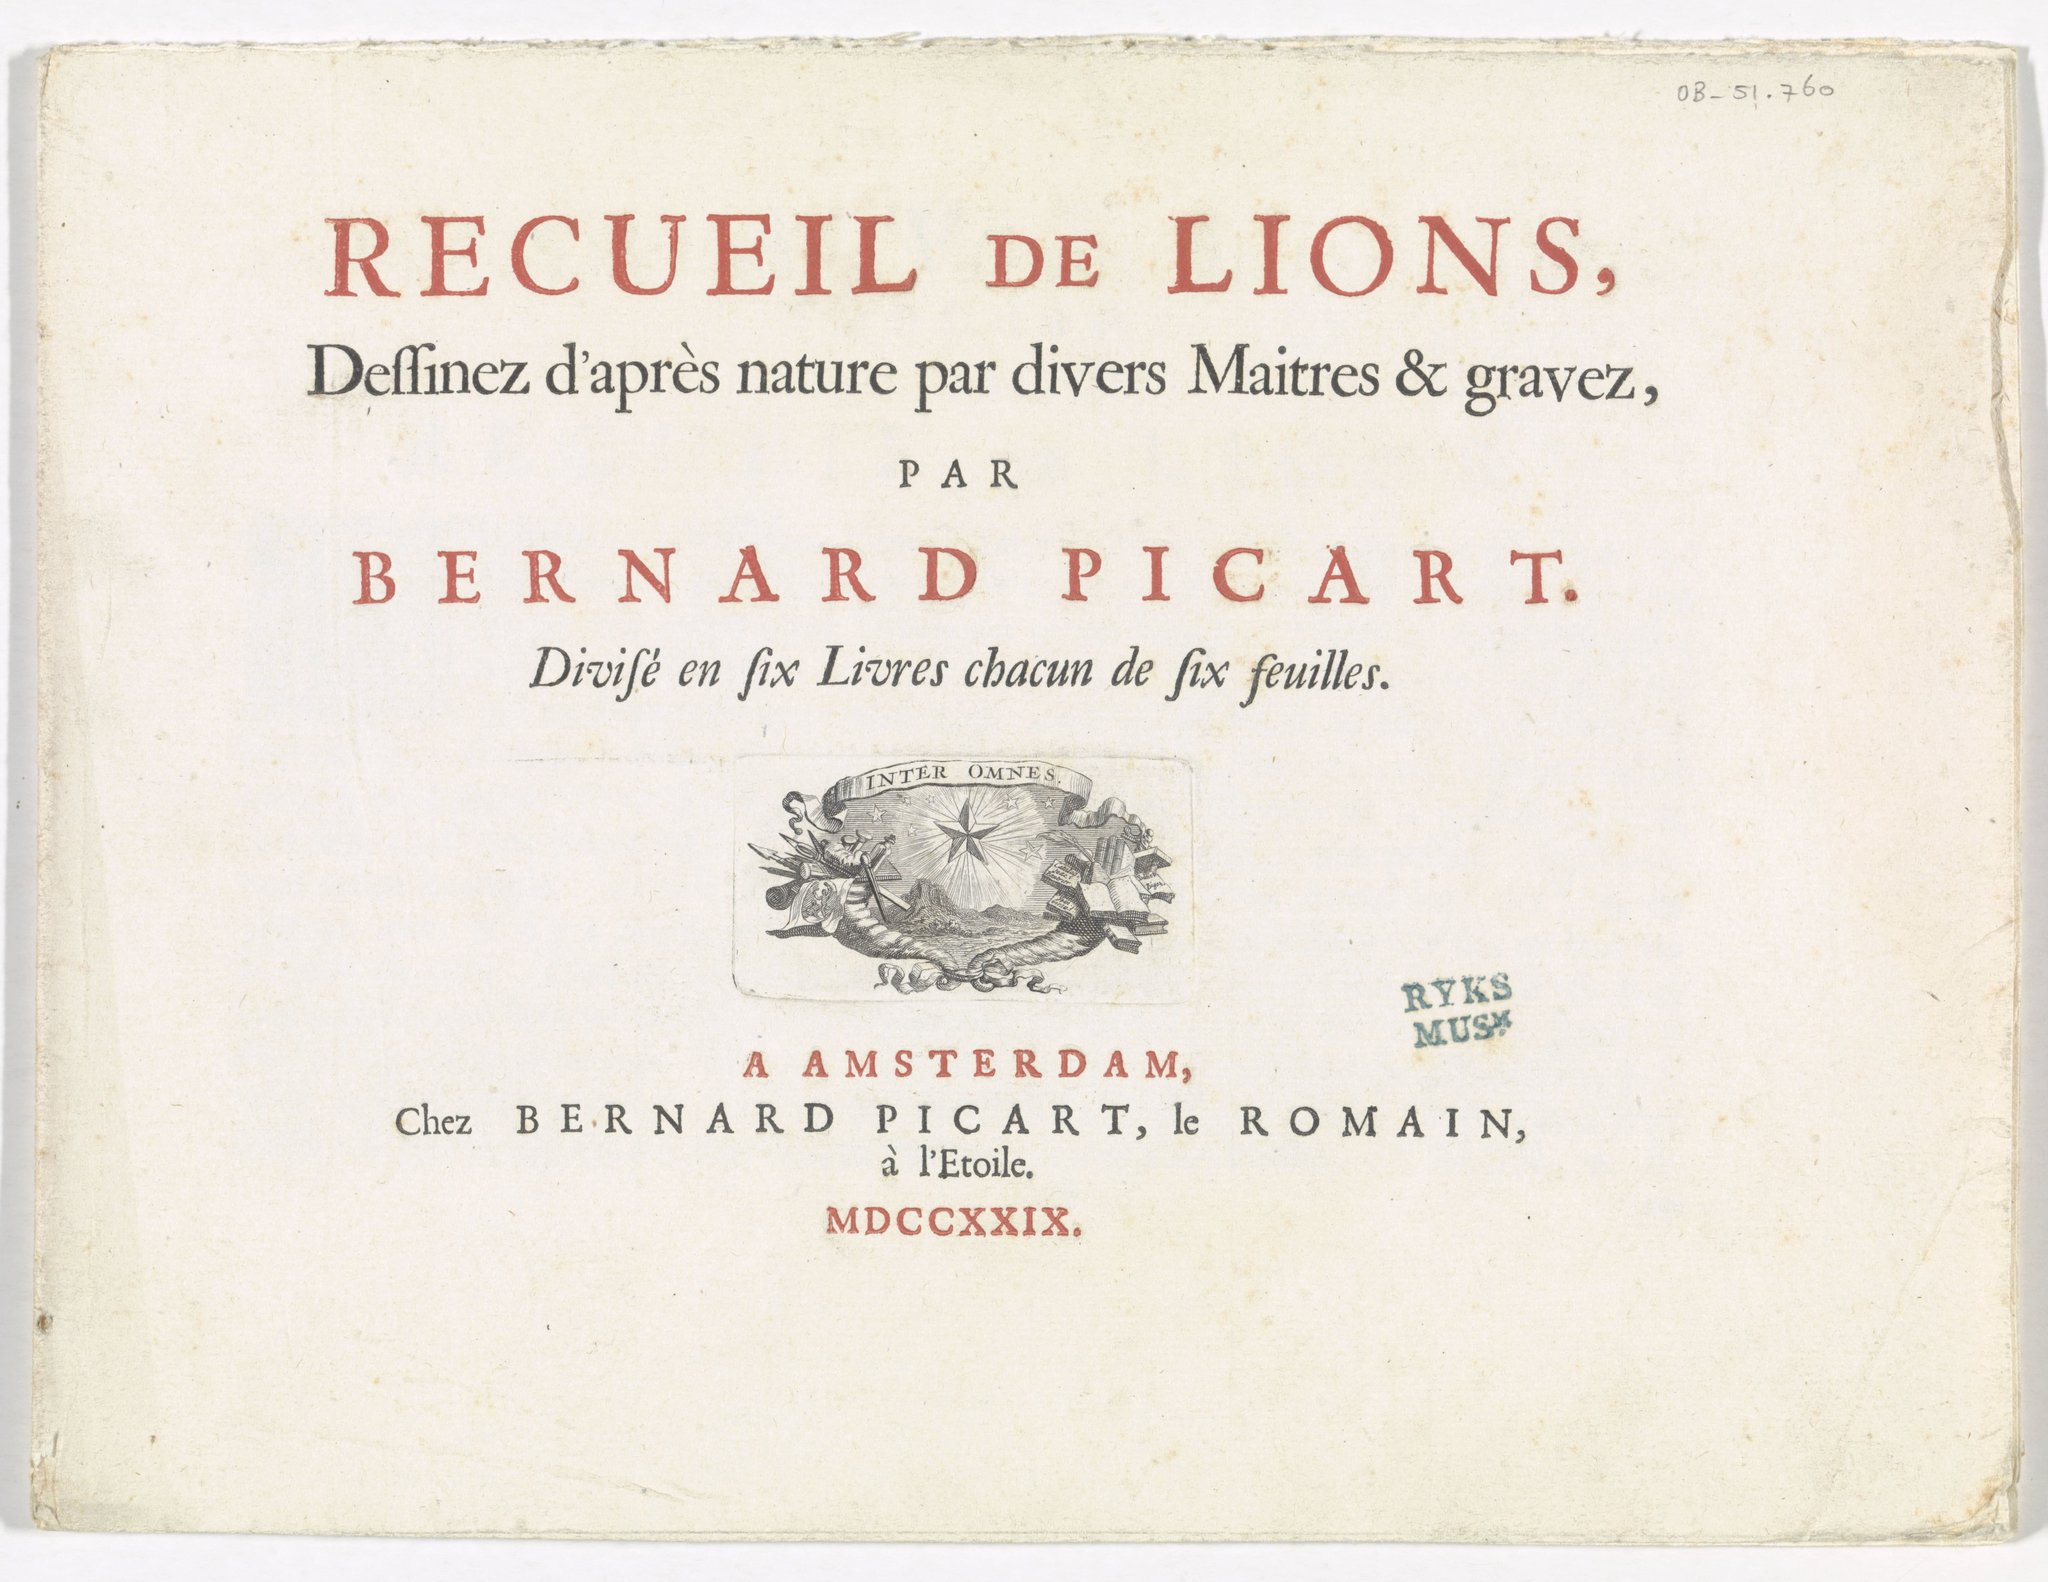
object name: book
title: Titelpagina voor: B. Picart, Recueil de lions, 1729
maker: bernard picart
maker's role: draughtsman, print maker, publisher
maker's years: 1673-1733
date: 1729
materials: paper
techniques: engraving, etching, letterpress printing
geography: amsterdam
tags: stars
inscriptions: collector's mark: Lugt 2165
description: Titelpagina voor het Recueil de lions met de titel en het impressum in het Frans. In het midden het vignet van Bernard Picart: een cartouche waarin een stralende ster, bekroond door een banderol met zijn devies "Inter Omnes". De titelpagina wordt gevolgd door een titelprent en zes bladzijden met een explicatie bij de prentseries die in de bundel zijn opgenomen, in boekdruk in het Frans.